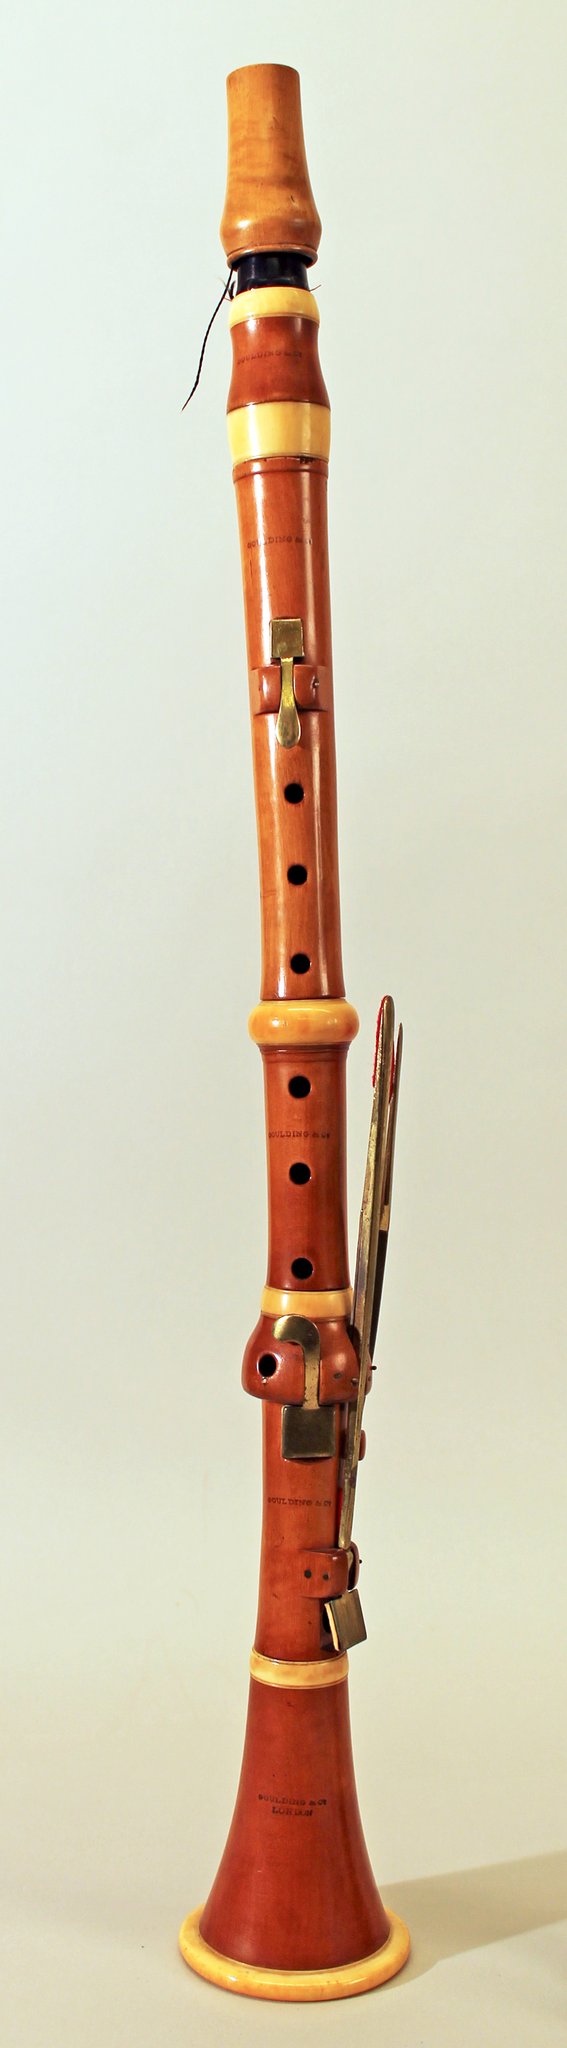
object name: clarinet in c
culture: british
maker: george goulding co.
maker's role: maker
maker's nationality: british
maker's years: 1785-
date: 1800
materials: wood, brass, ivory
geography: united kingdom